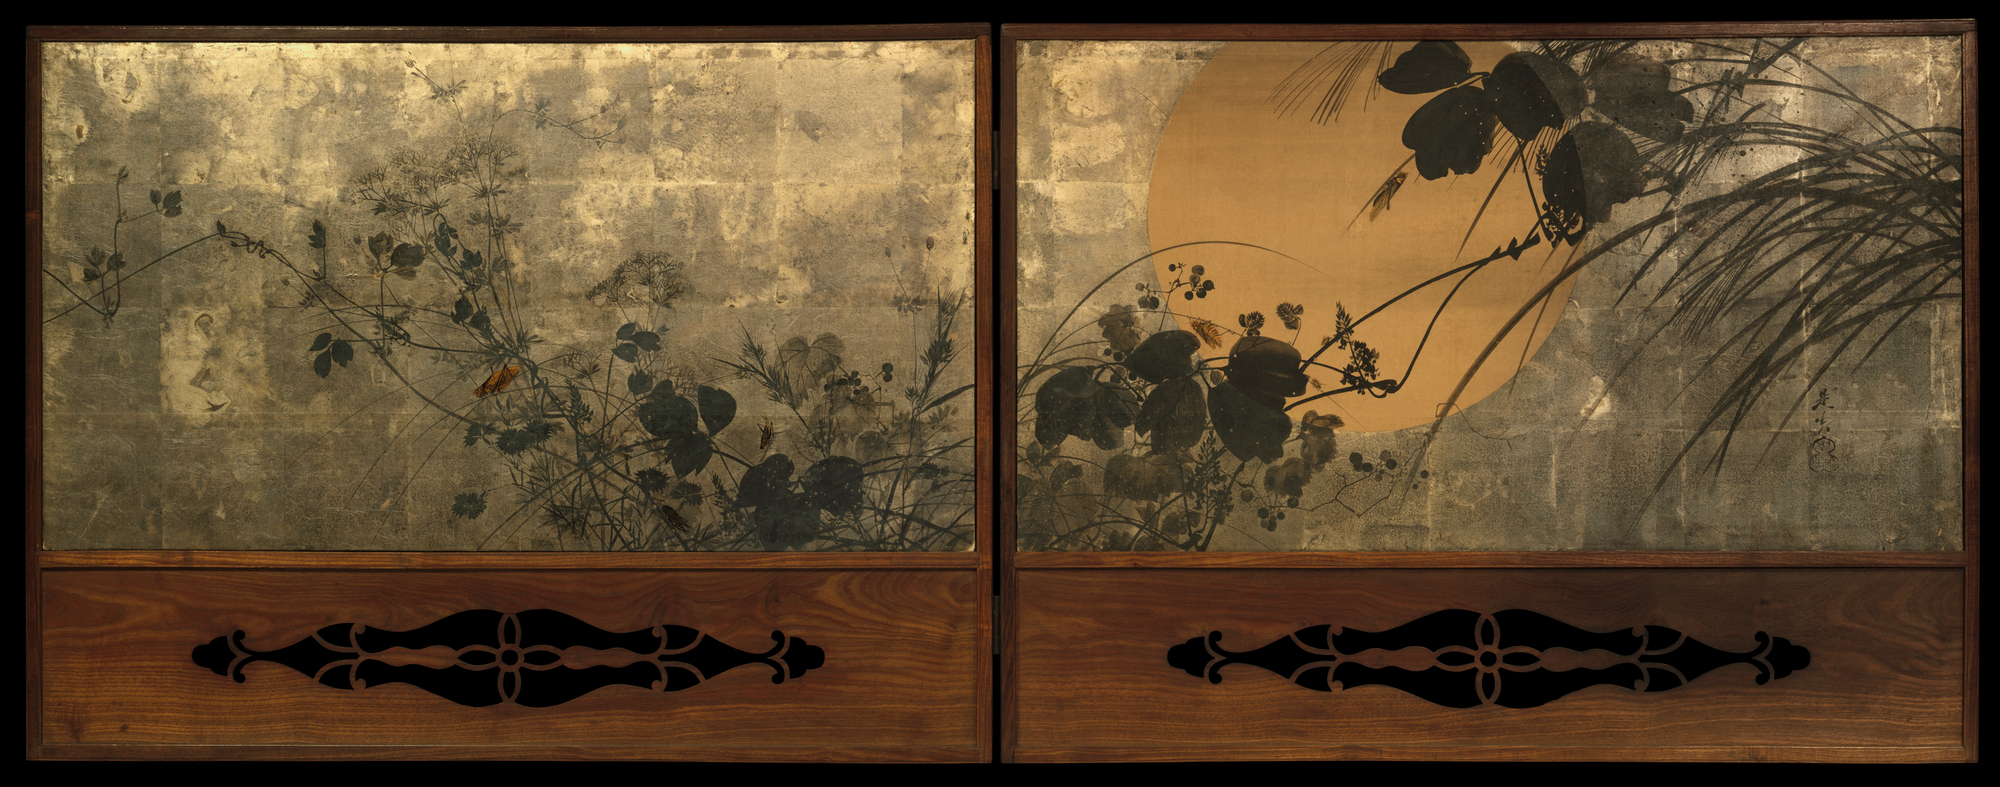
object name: screen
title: Autumn Grasses in Moonlight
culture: japanese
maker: shibata zeshin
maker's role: artist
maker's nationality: japanese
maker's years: 1807-1891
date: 1851-1900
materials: ink, lacquer, panel, paper, silver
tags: moon,plants